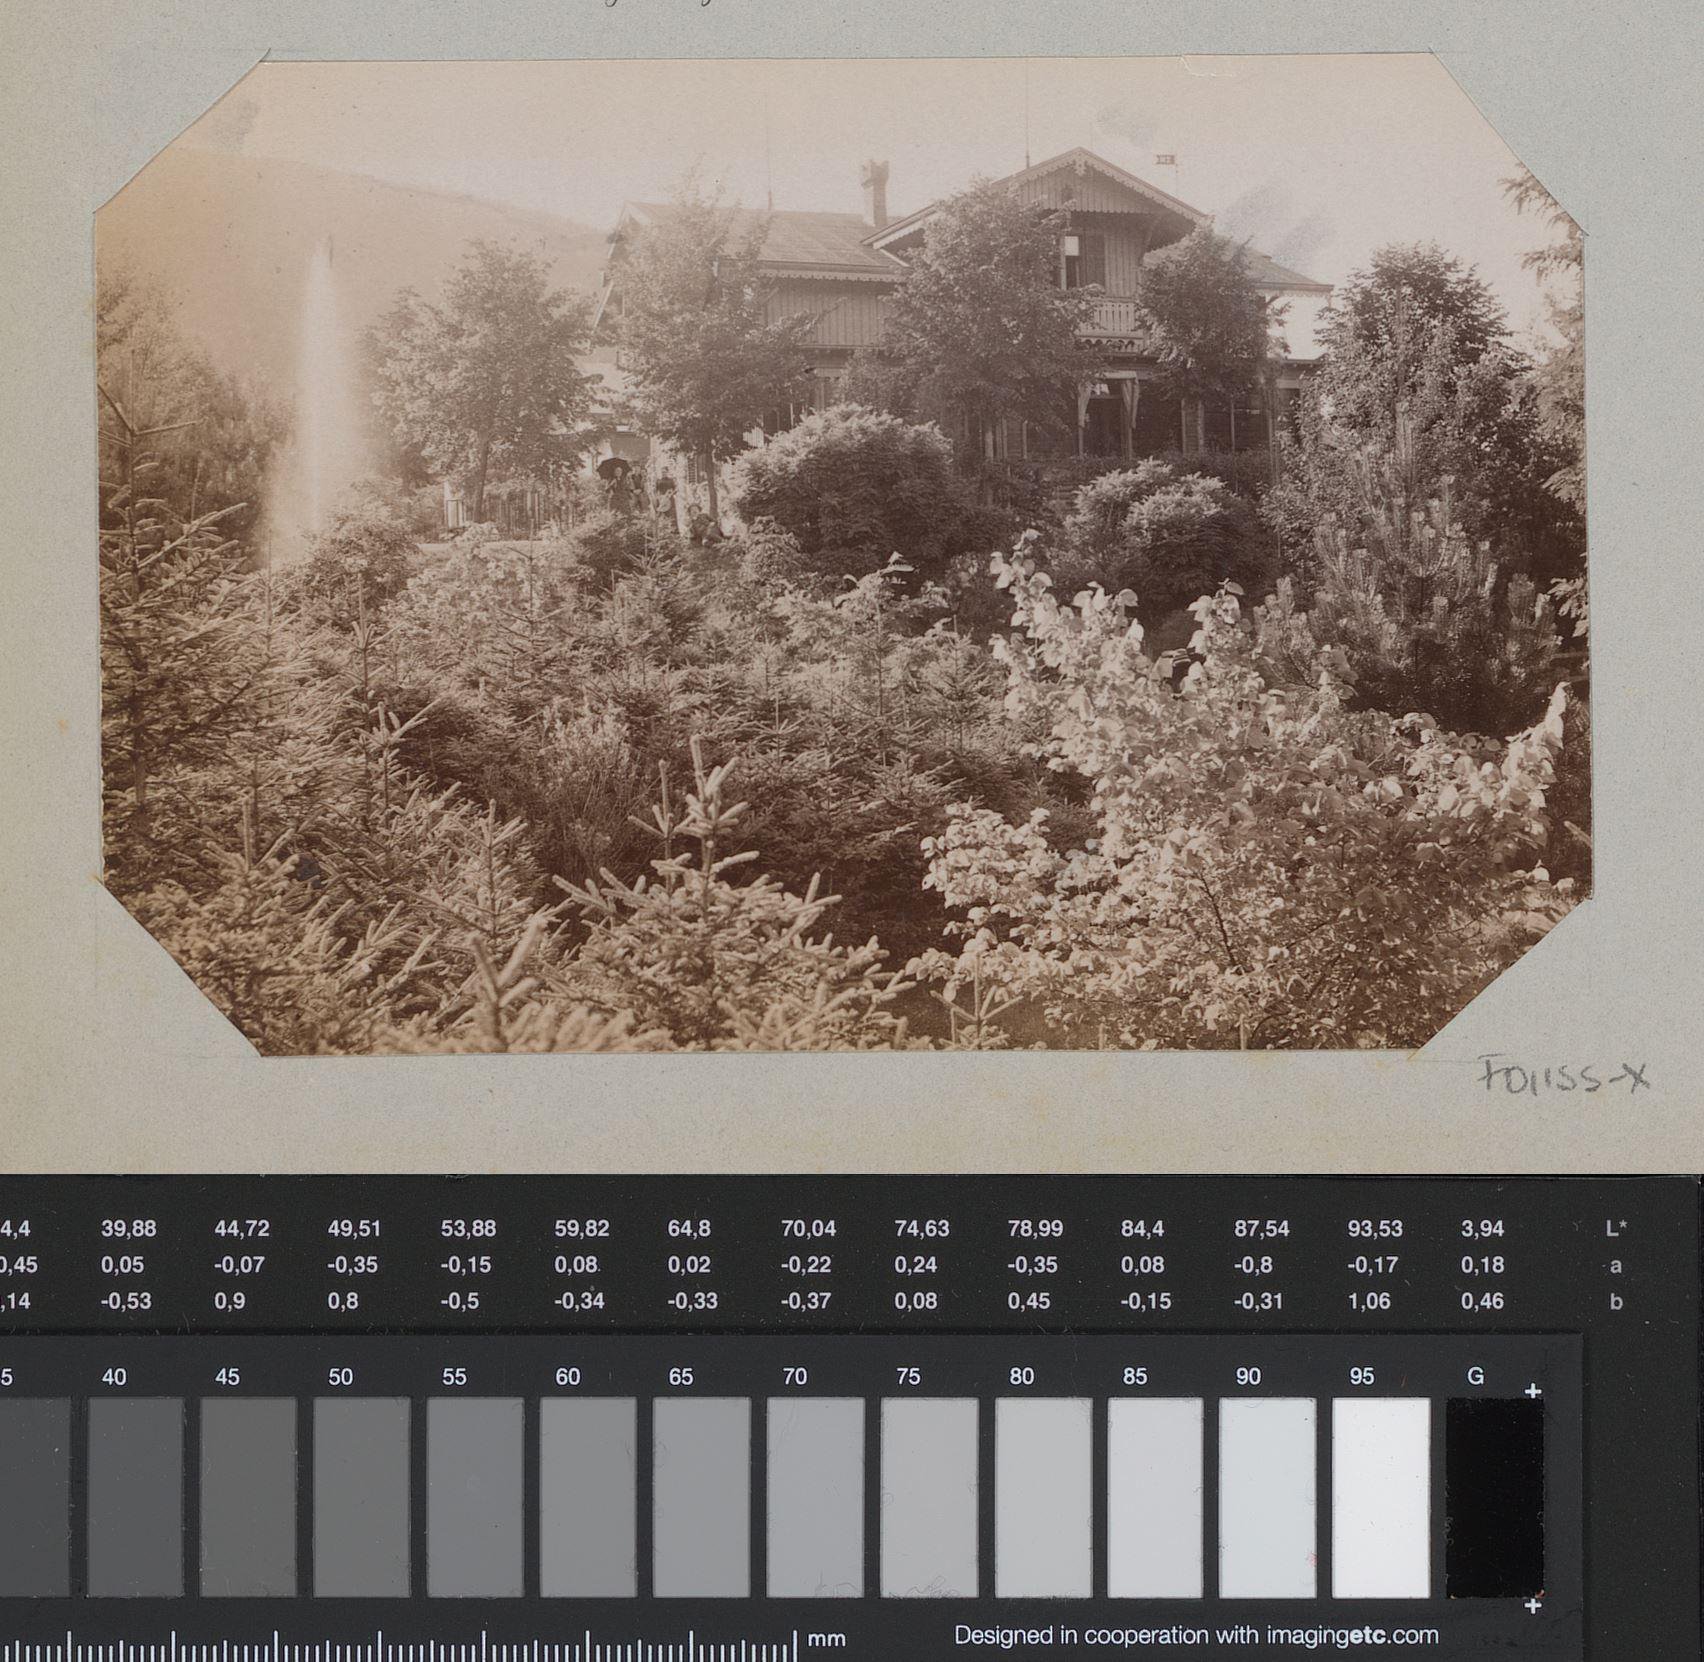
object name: photograph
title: Huis Johannaberg bij Berlebeck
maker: Anonymous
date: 1890-1897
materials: photographic support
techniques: albumen print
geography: detmold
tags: rural housing, e.g. country-house, villa, cottage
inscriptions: annotation: ‘Johannaberg bij Berlebeck’